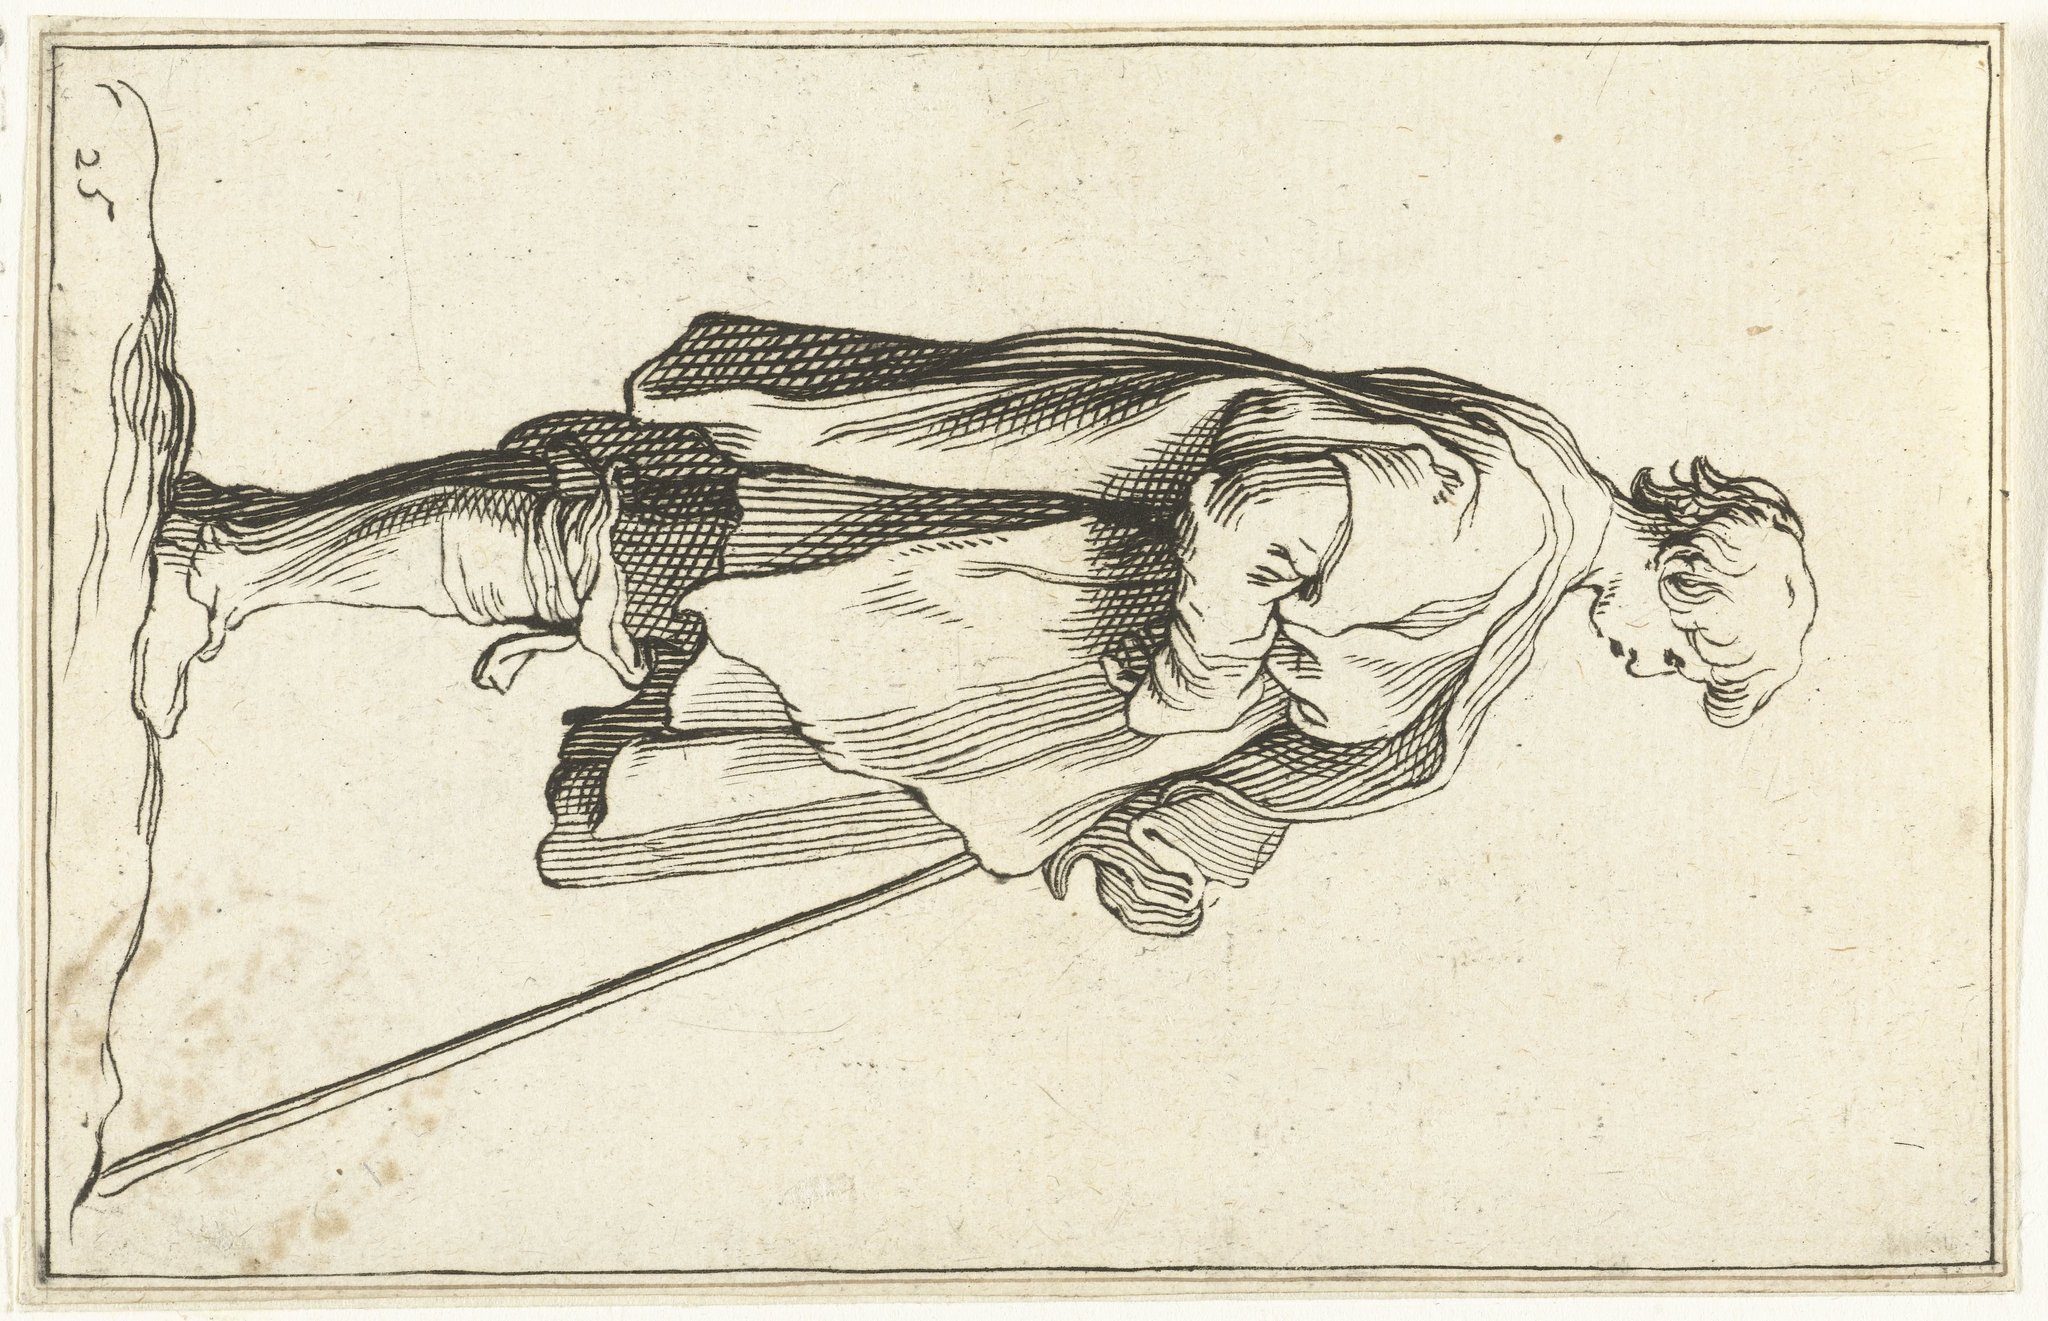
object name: print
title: Jonge boer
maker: frederick bloemaert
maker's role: print maker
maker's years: 1614-1669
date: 1635-1669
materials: paper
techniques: engraving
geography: utrecht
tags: farmers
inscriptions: collector's mark: Lugt 240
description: Man, zijwaarts afgebeeld, met lange jas en stok in de linkerhand.